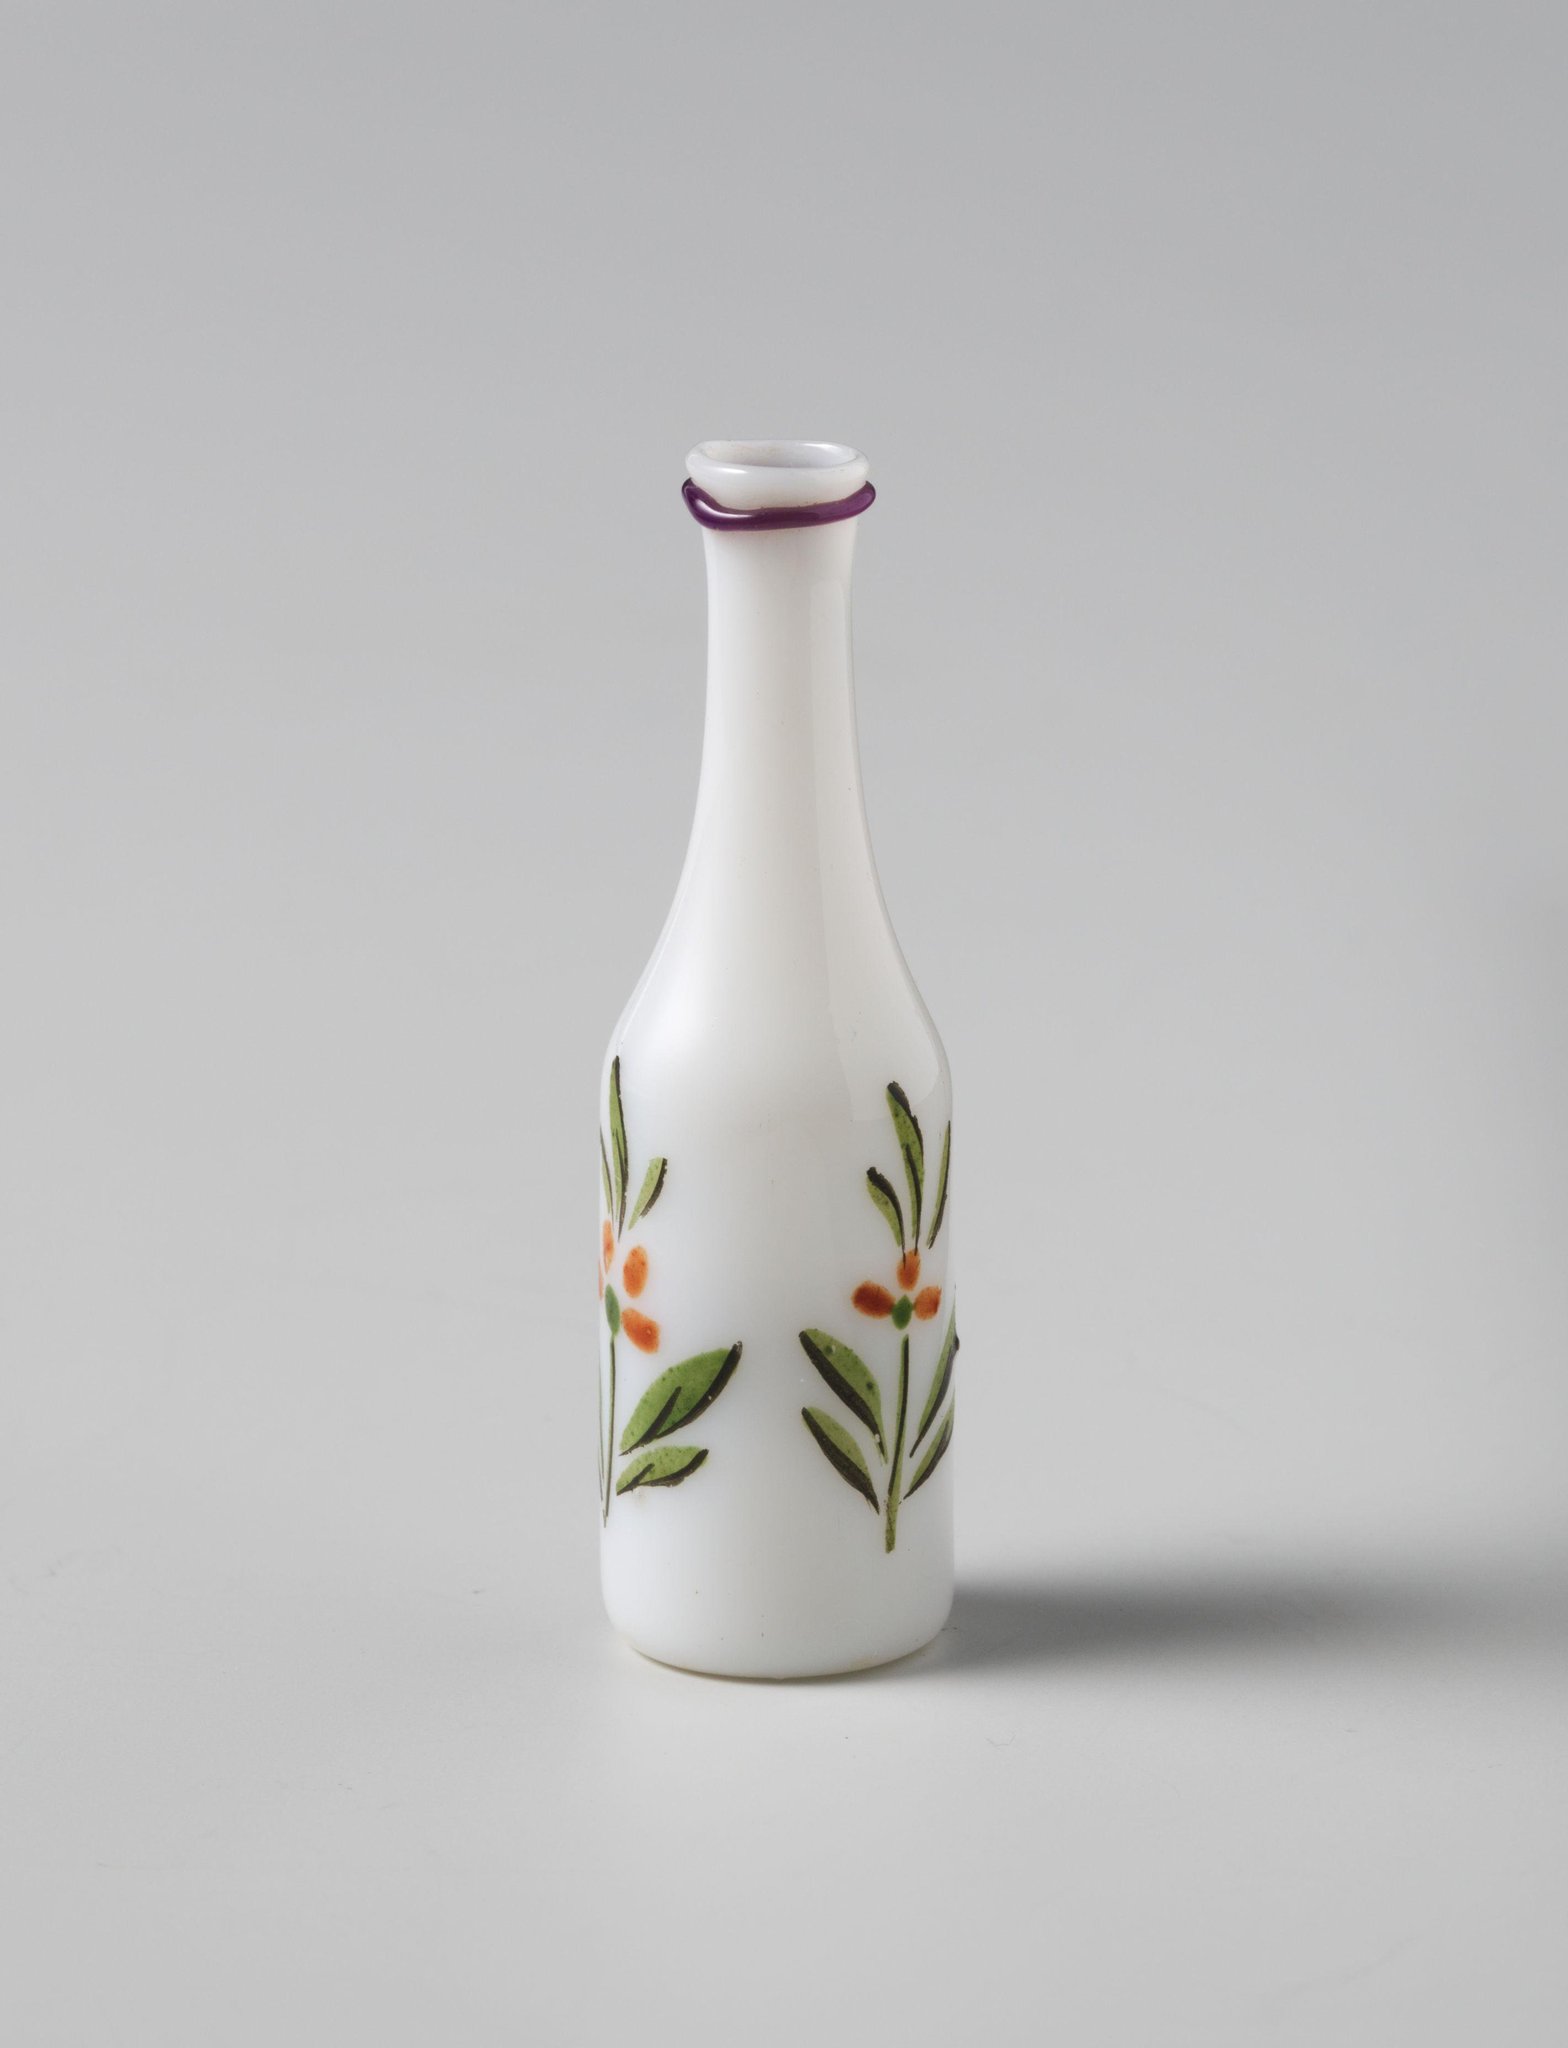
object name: miniature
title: Fles, beschilderd met bloemen in groen, zwart en rood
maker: Anonymous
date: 1800-1849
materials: glass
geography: bristol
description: Fles van opaak wit glas, cilindrisch, met vlakke, iets naar binnen gestoken bodem, smalle hals met blauwe glasdraad rond de mond. De buik beschilderd met bloemen in groen, zwart en rood.